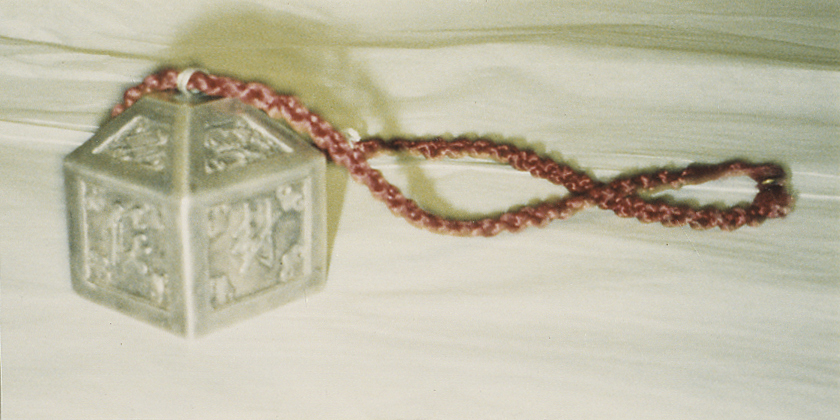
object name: seal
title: Rattle in the Form of an Official Seal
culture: chinese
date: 1867-1933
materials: cord, silk, silver